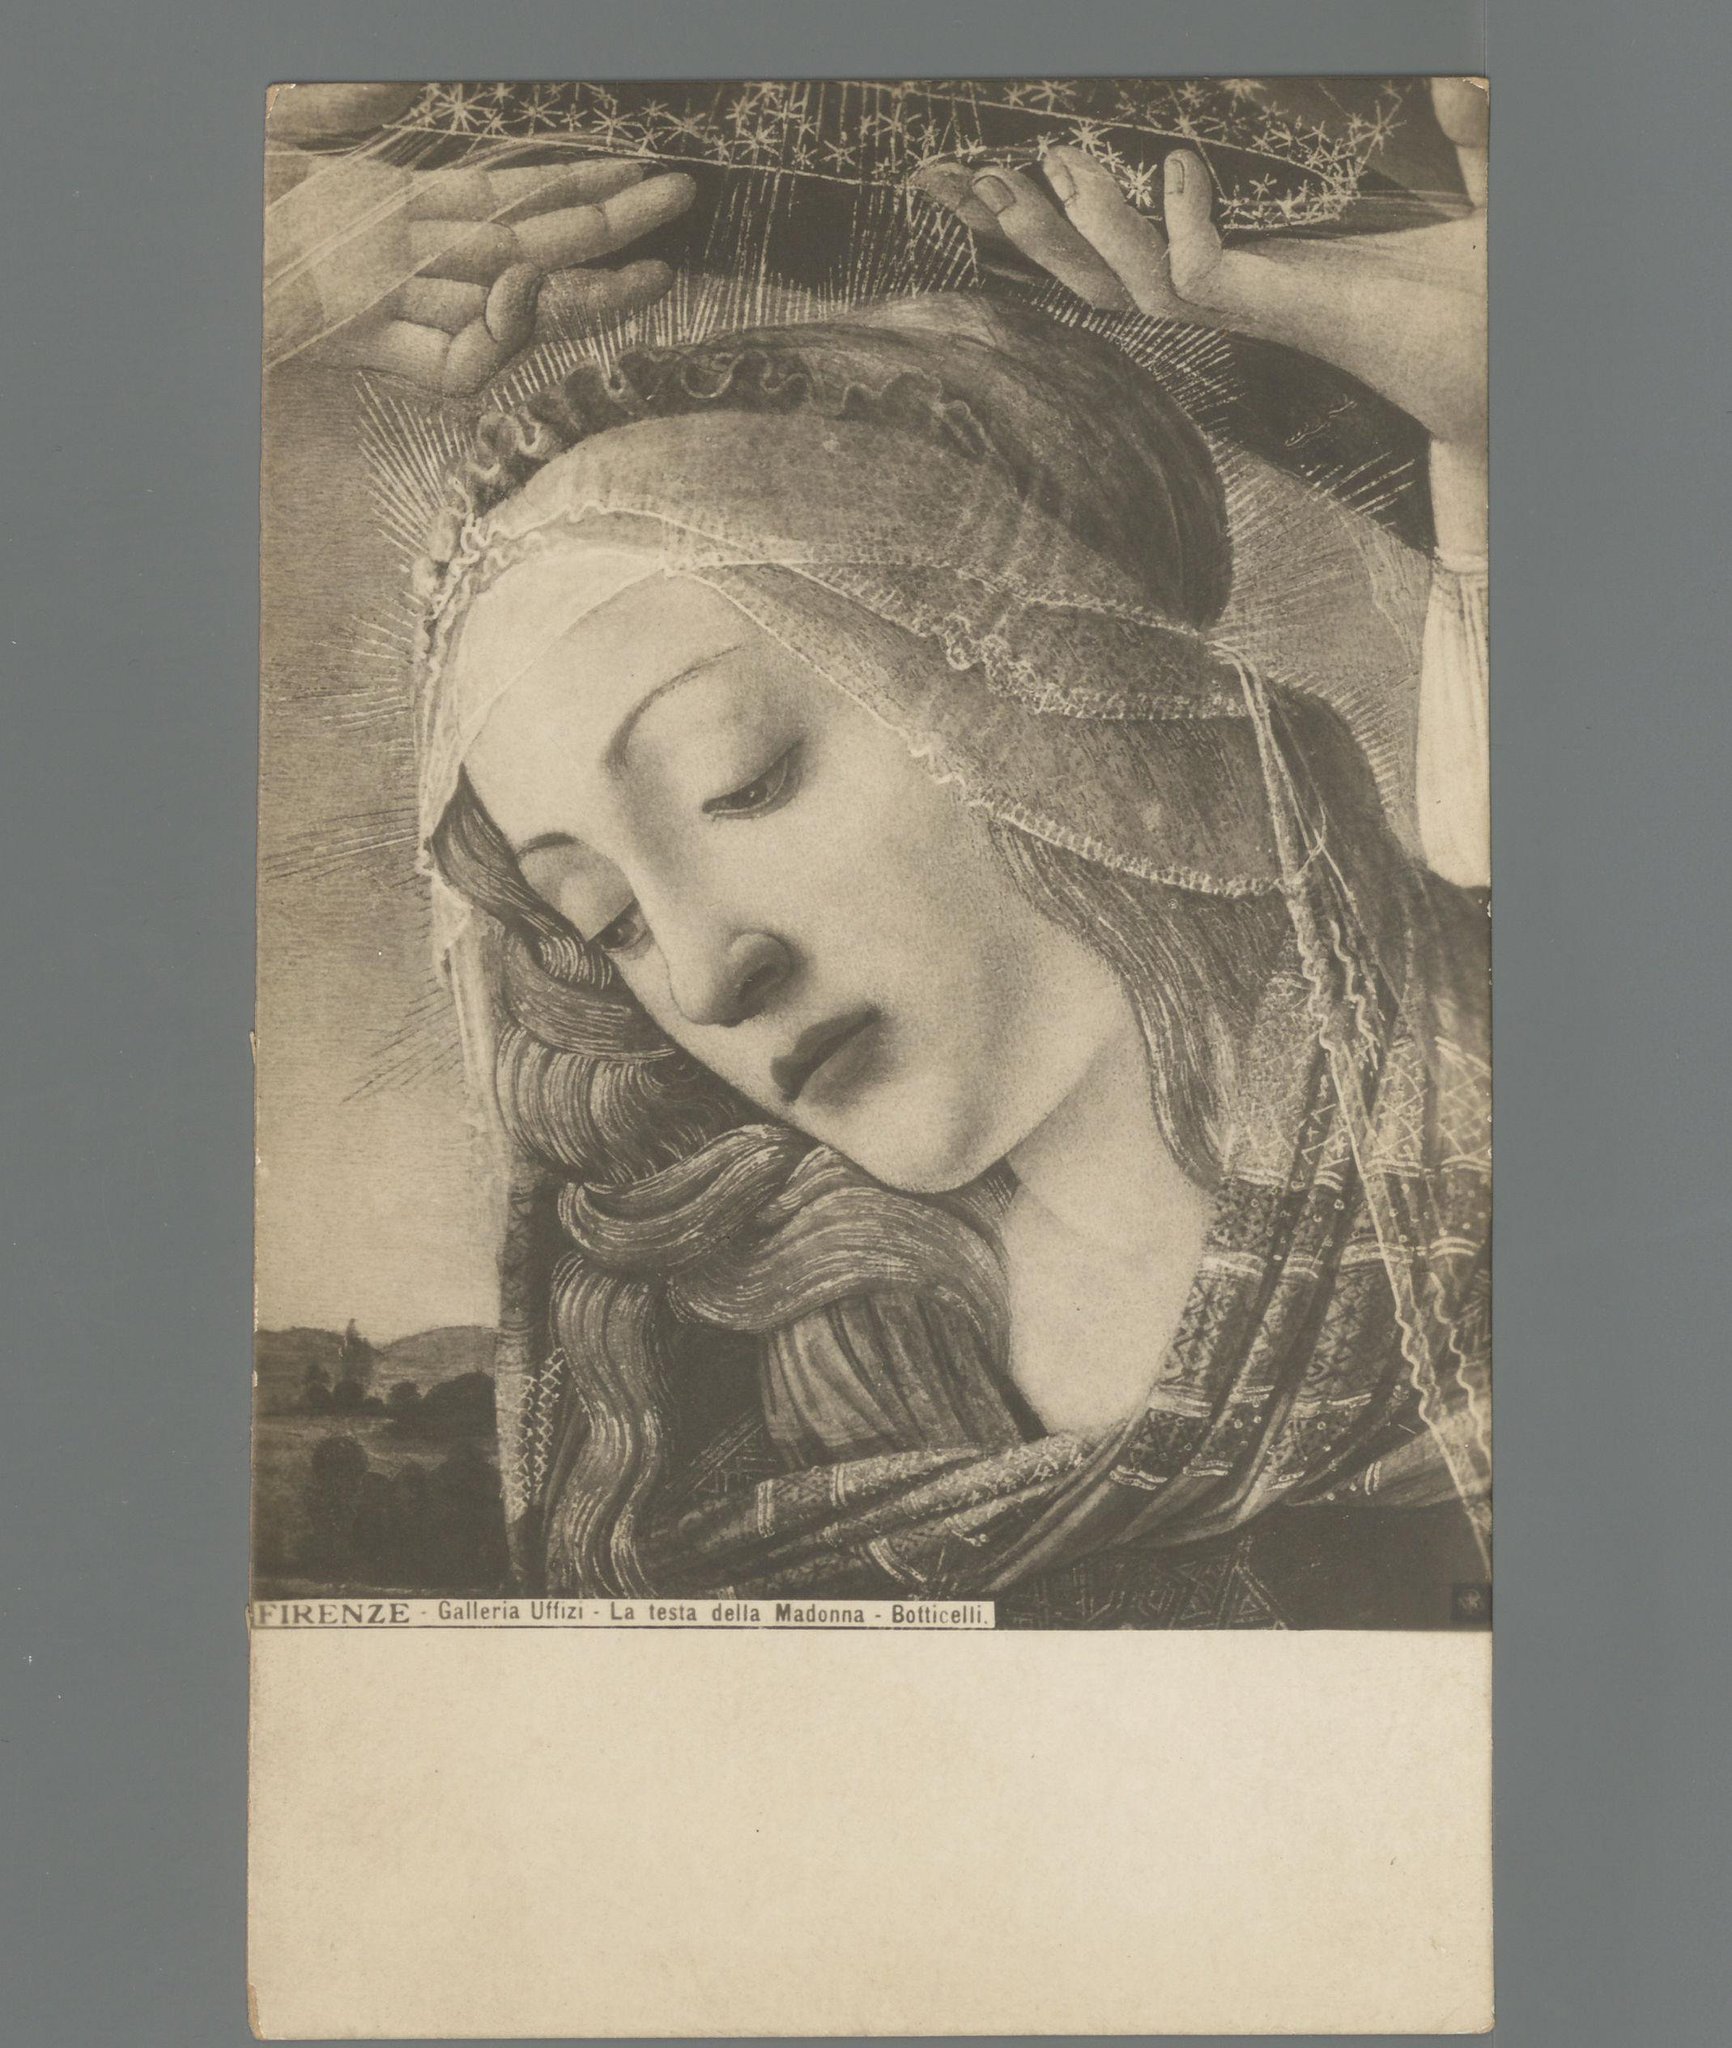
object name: ansichtkaart, prentbriefkaart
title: Firenze - Galleria Uffizi - La testa della Madonna - Botticelli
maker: Anonymous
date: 1900-1905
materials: paper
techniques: gelatin silver print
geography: florence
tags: permanent exhibition, museum, picture, painting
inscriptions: collector's mark: ‘AFE v S’, monogram